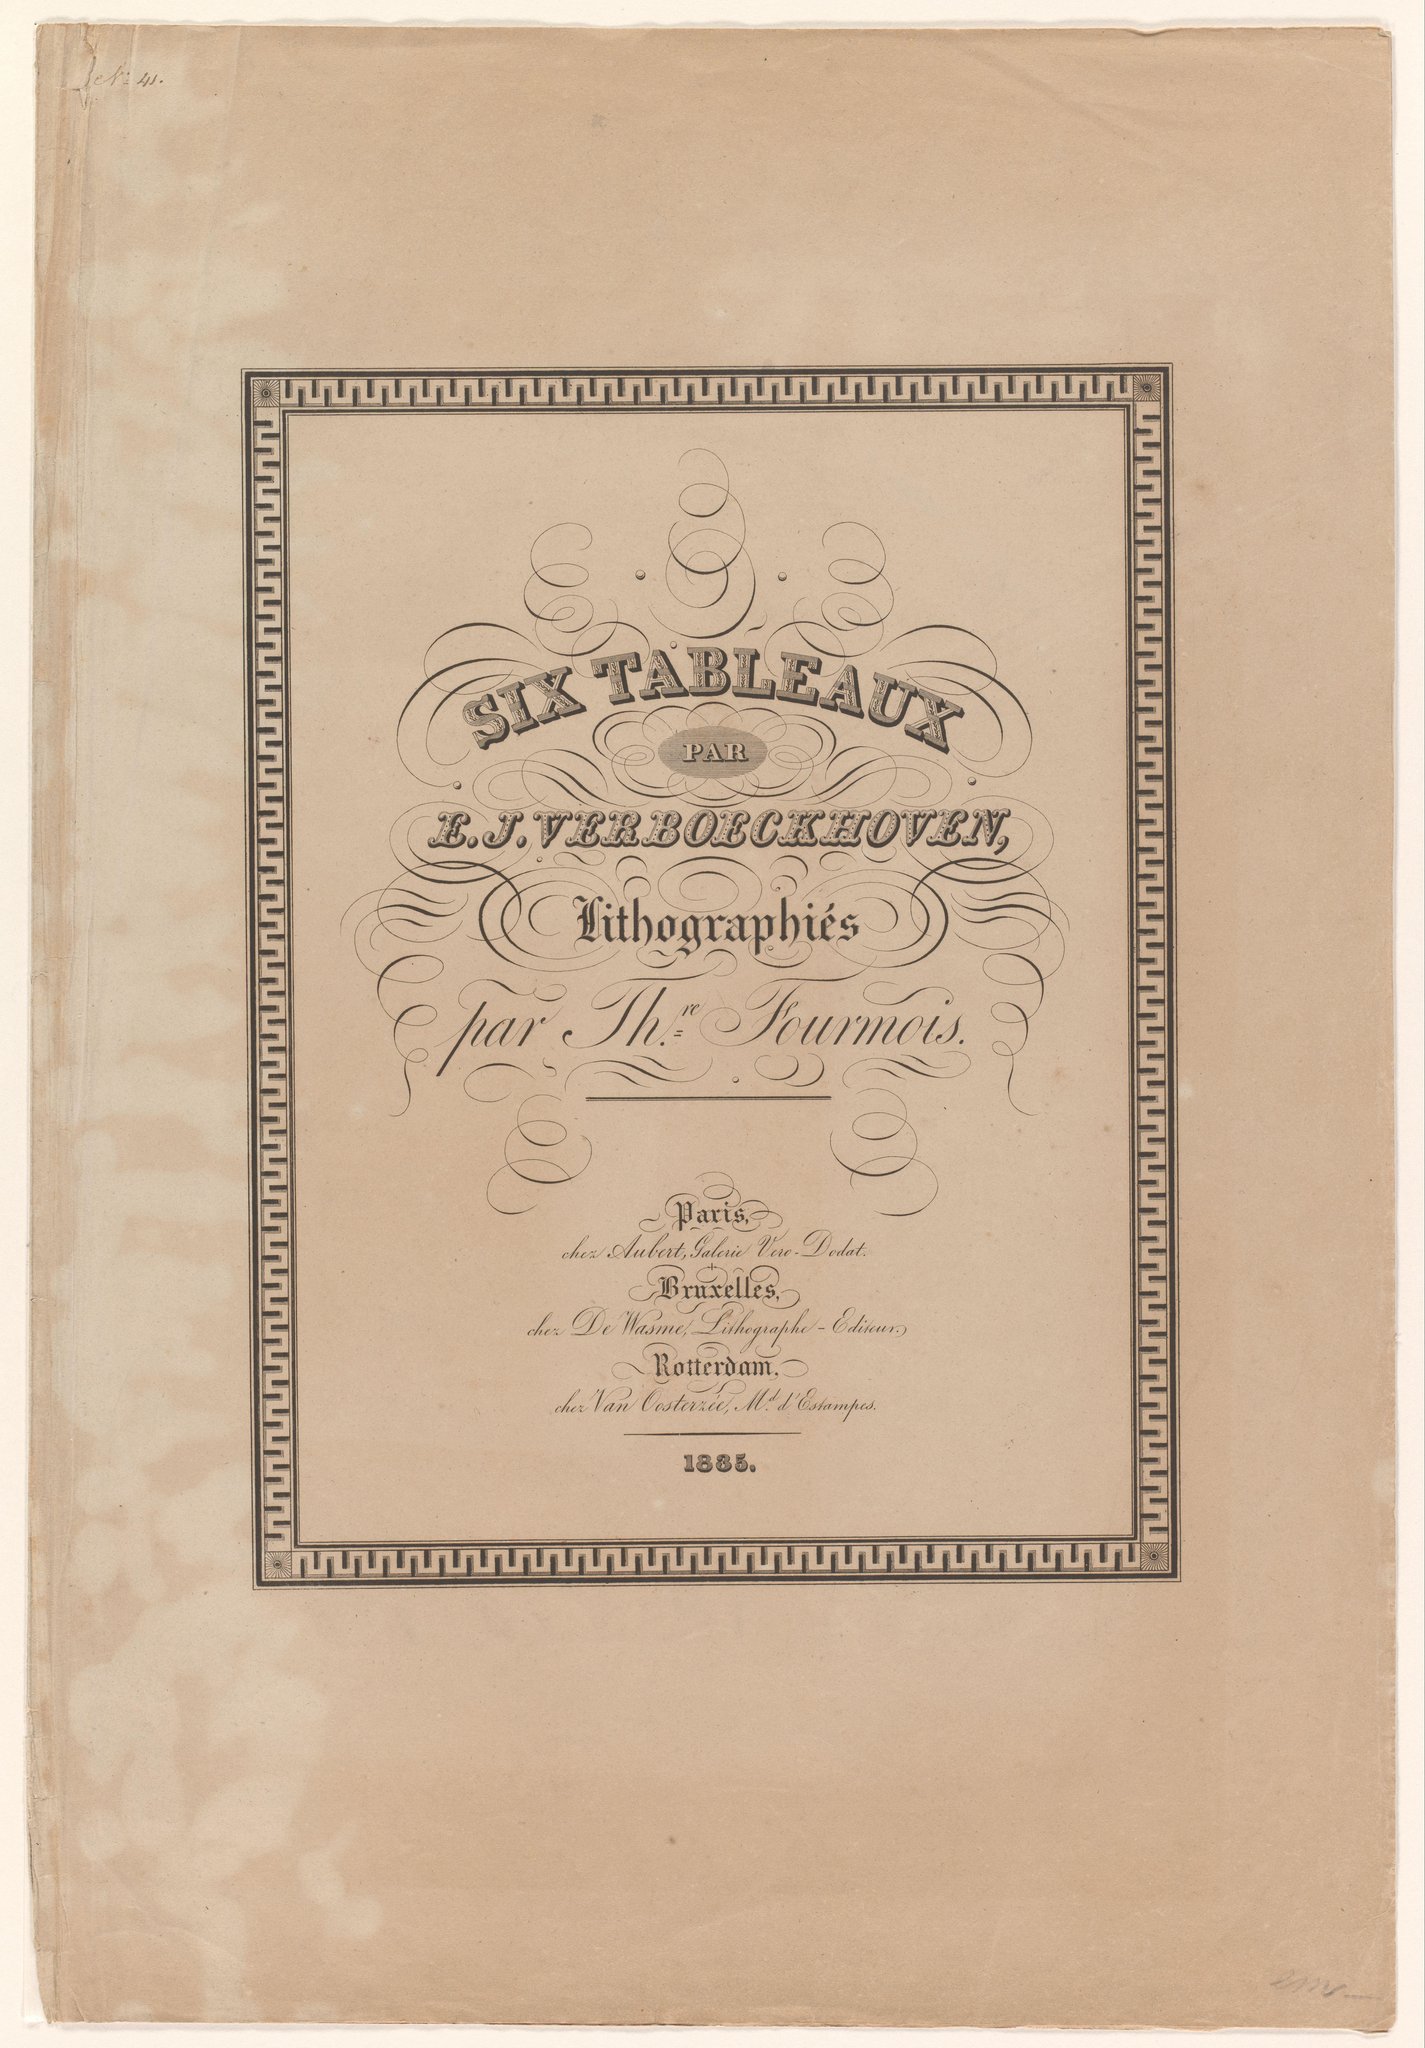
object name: wrapper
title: Zes landschappen met dieren door Théodore Fourmois naar schilderijen van Eugène Verboeckhoven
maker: théodore fourmois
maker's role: print maker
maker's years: 1814-1871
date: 1835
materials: paper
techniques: lithograph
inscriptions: collector's mark: Lugt 2228